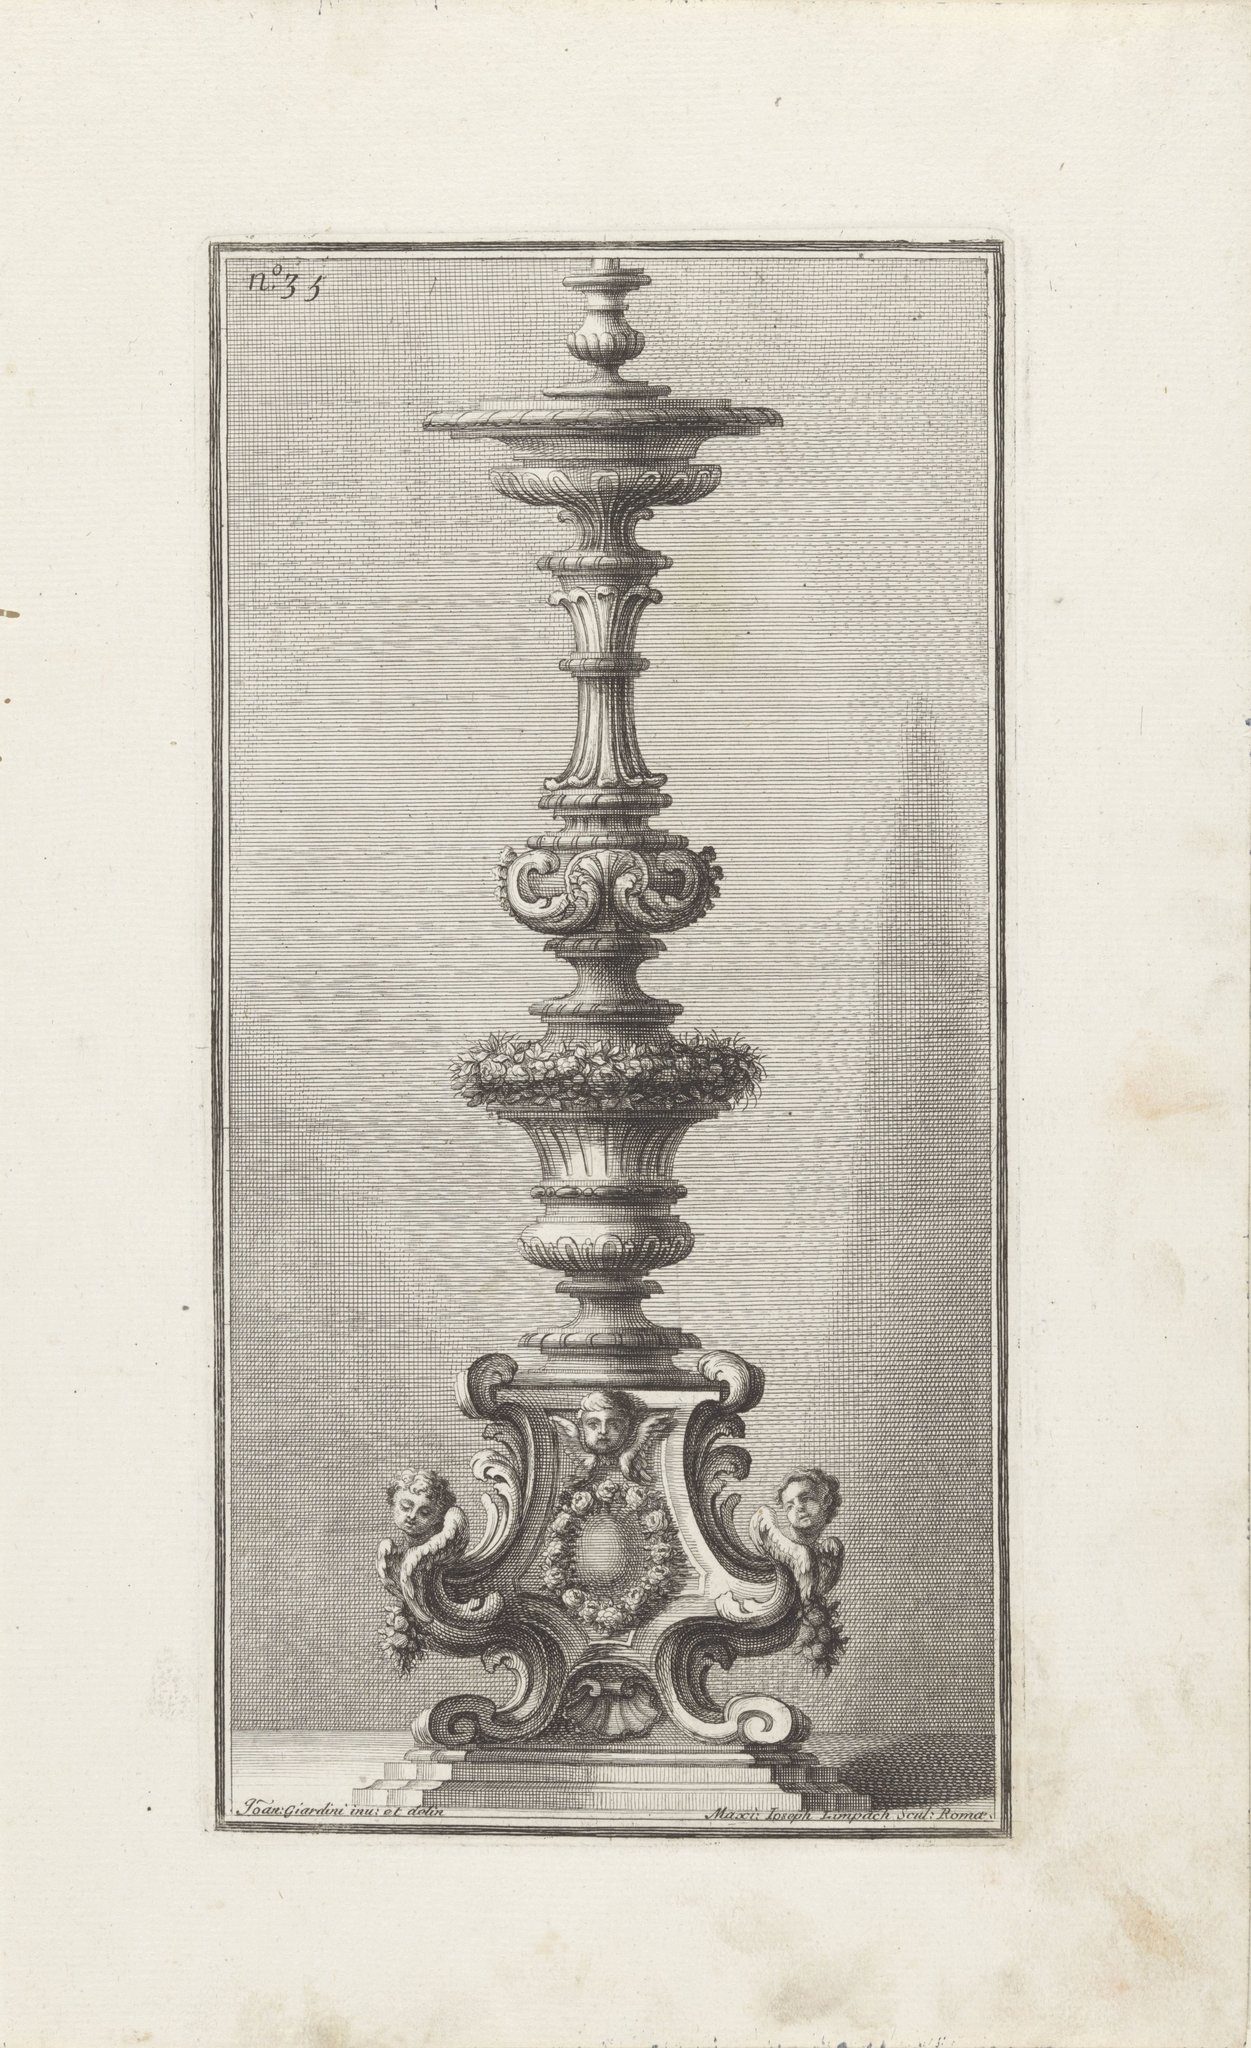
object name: ornament print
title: Diverse kerkelijke voorwerpen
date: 1714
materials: paper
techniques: etching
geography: rome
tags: cherubs, i.e. children's heads with wings, chandelier, candelabrum, ornament ~ candelabrum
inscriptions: collector's mark: Lugt 2228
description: Prent maakt deel uit van een reeks van 100 ornamentprenten naar ontwerp van Giovanni Giardini.